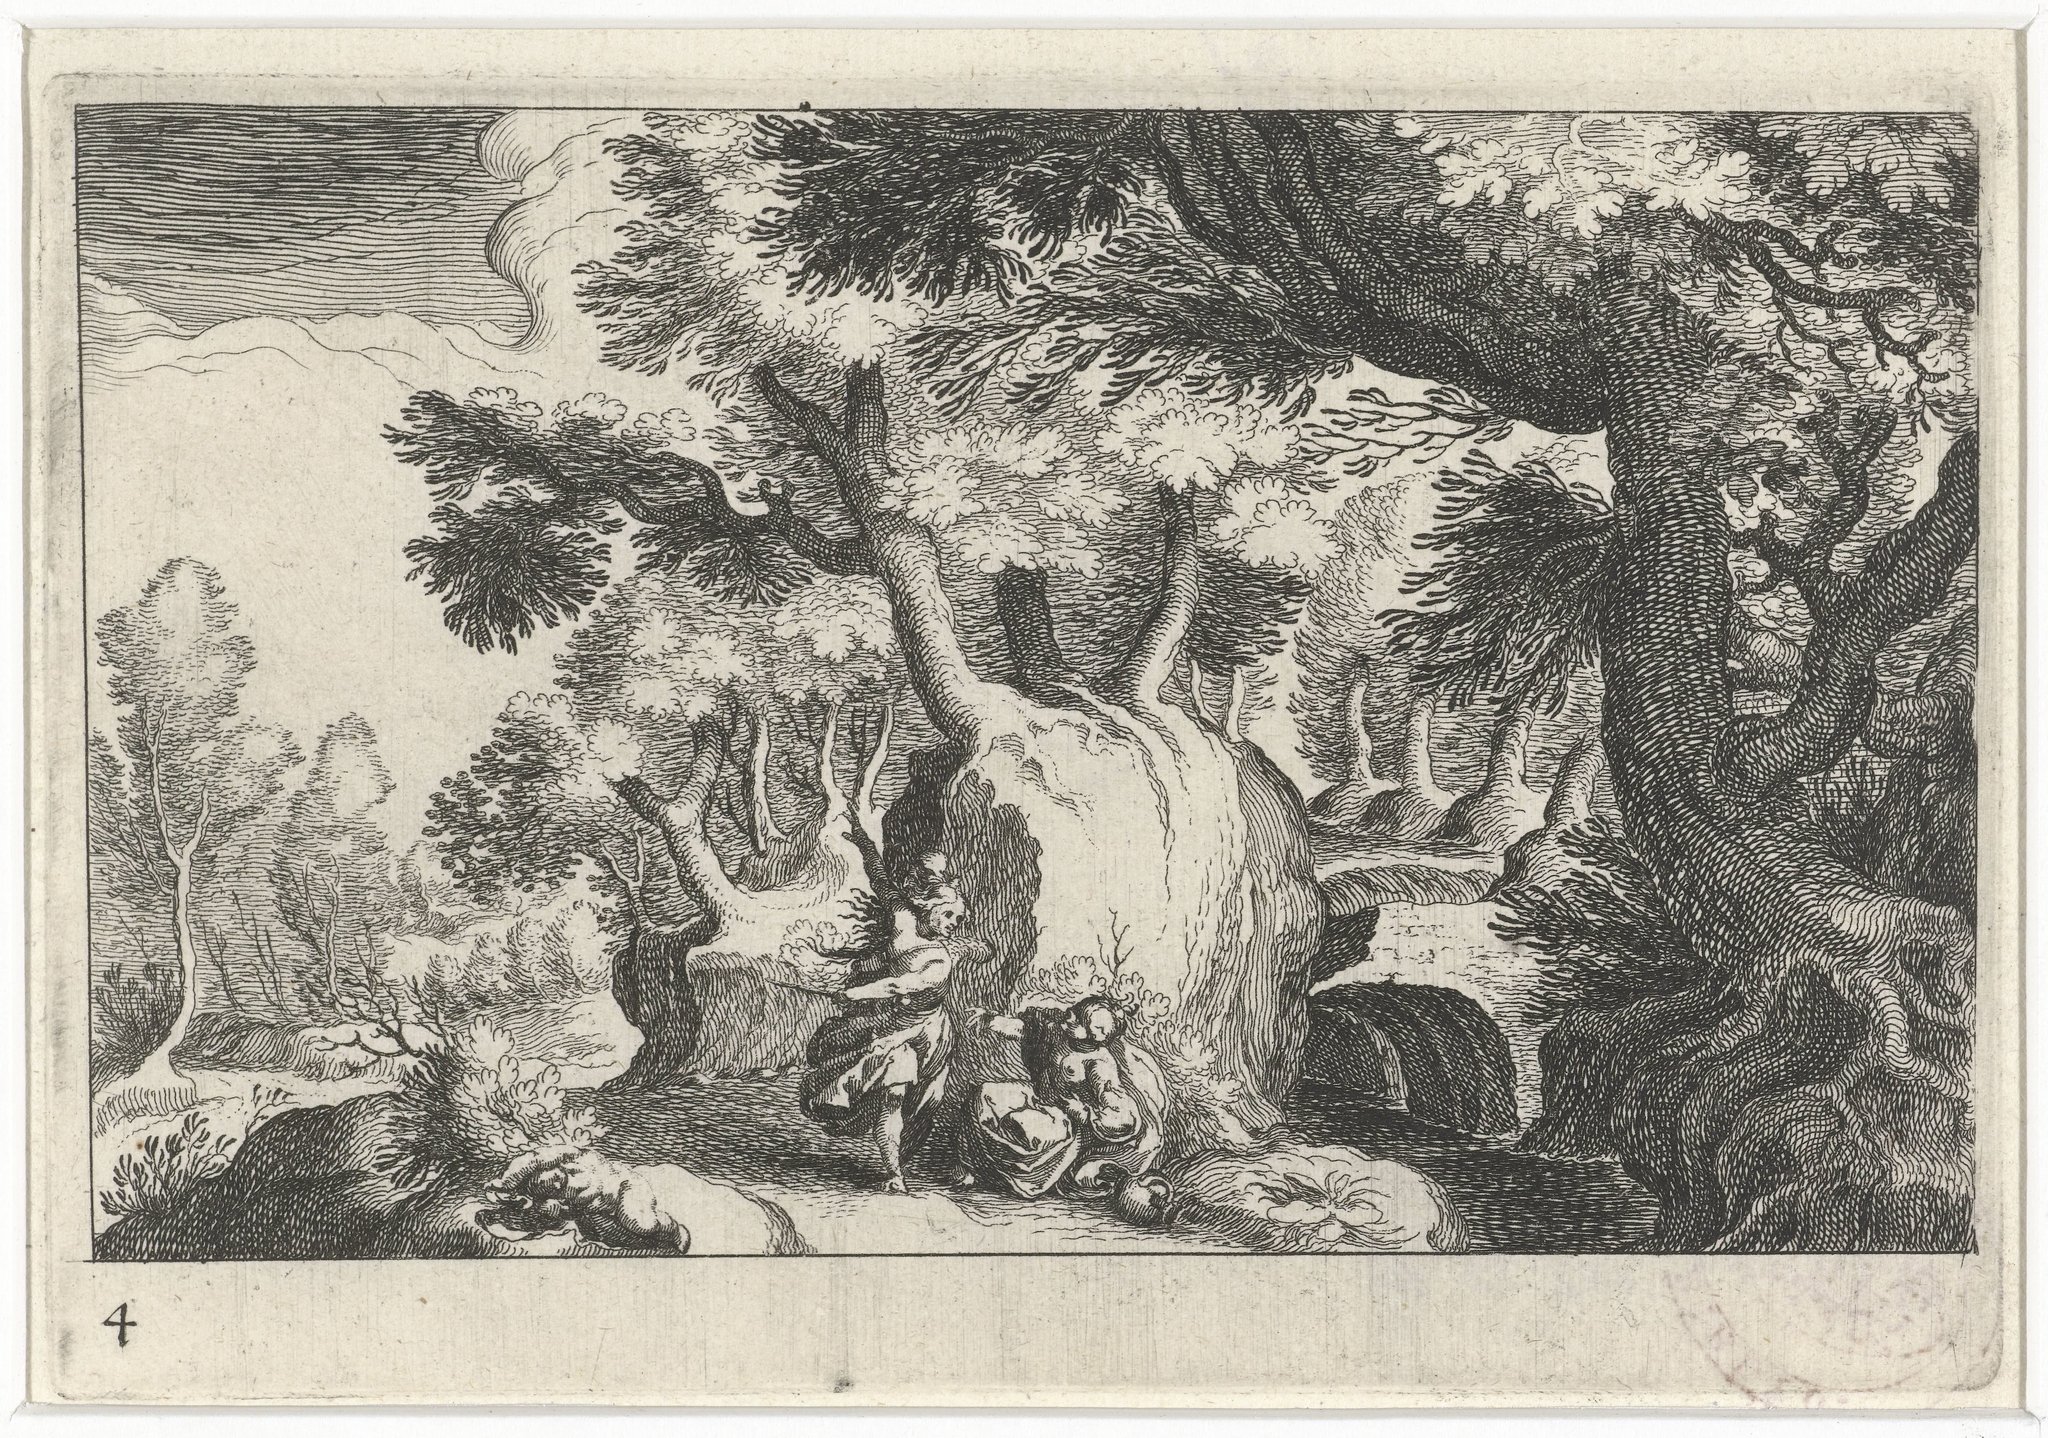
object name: print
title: Zuid-Europese landschappen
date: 1611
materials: paper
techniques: etching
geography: the hague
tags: an angel appears and reveals a well of water to hagar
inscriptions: collector's mark: Lugt 240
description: Een engel wijst Hagar de weg. Op de voorgrond ligt Ismaël onder een struik.